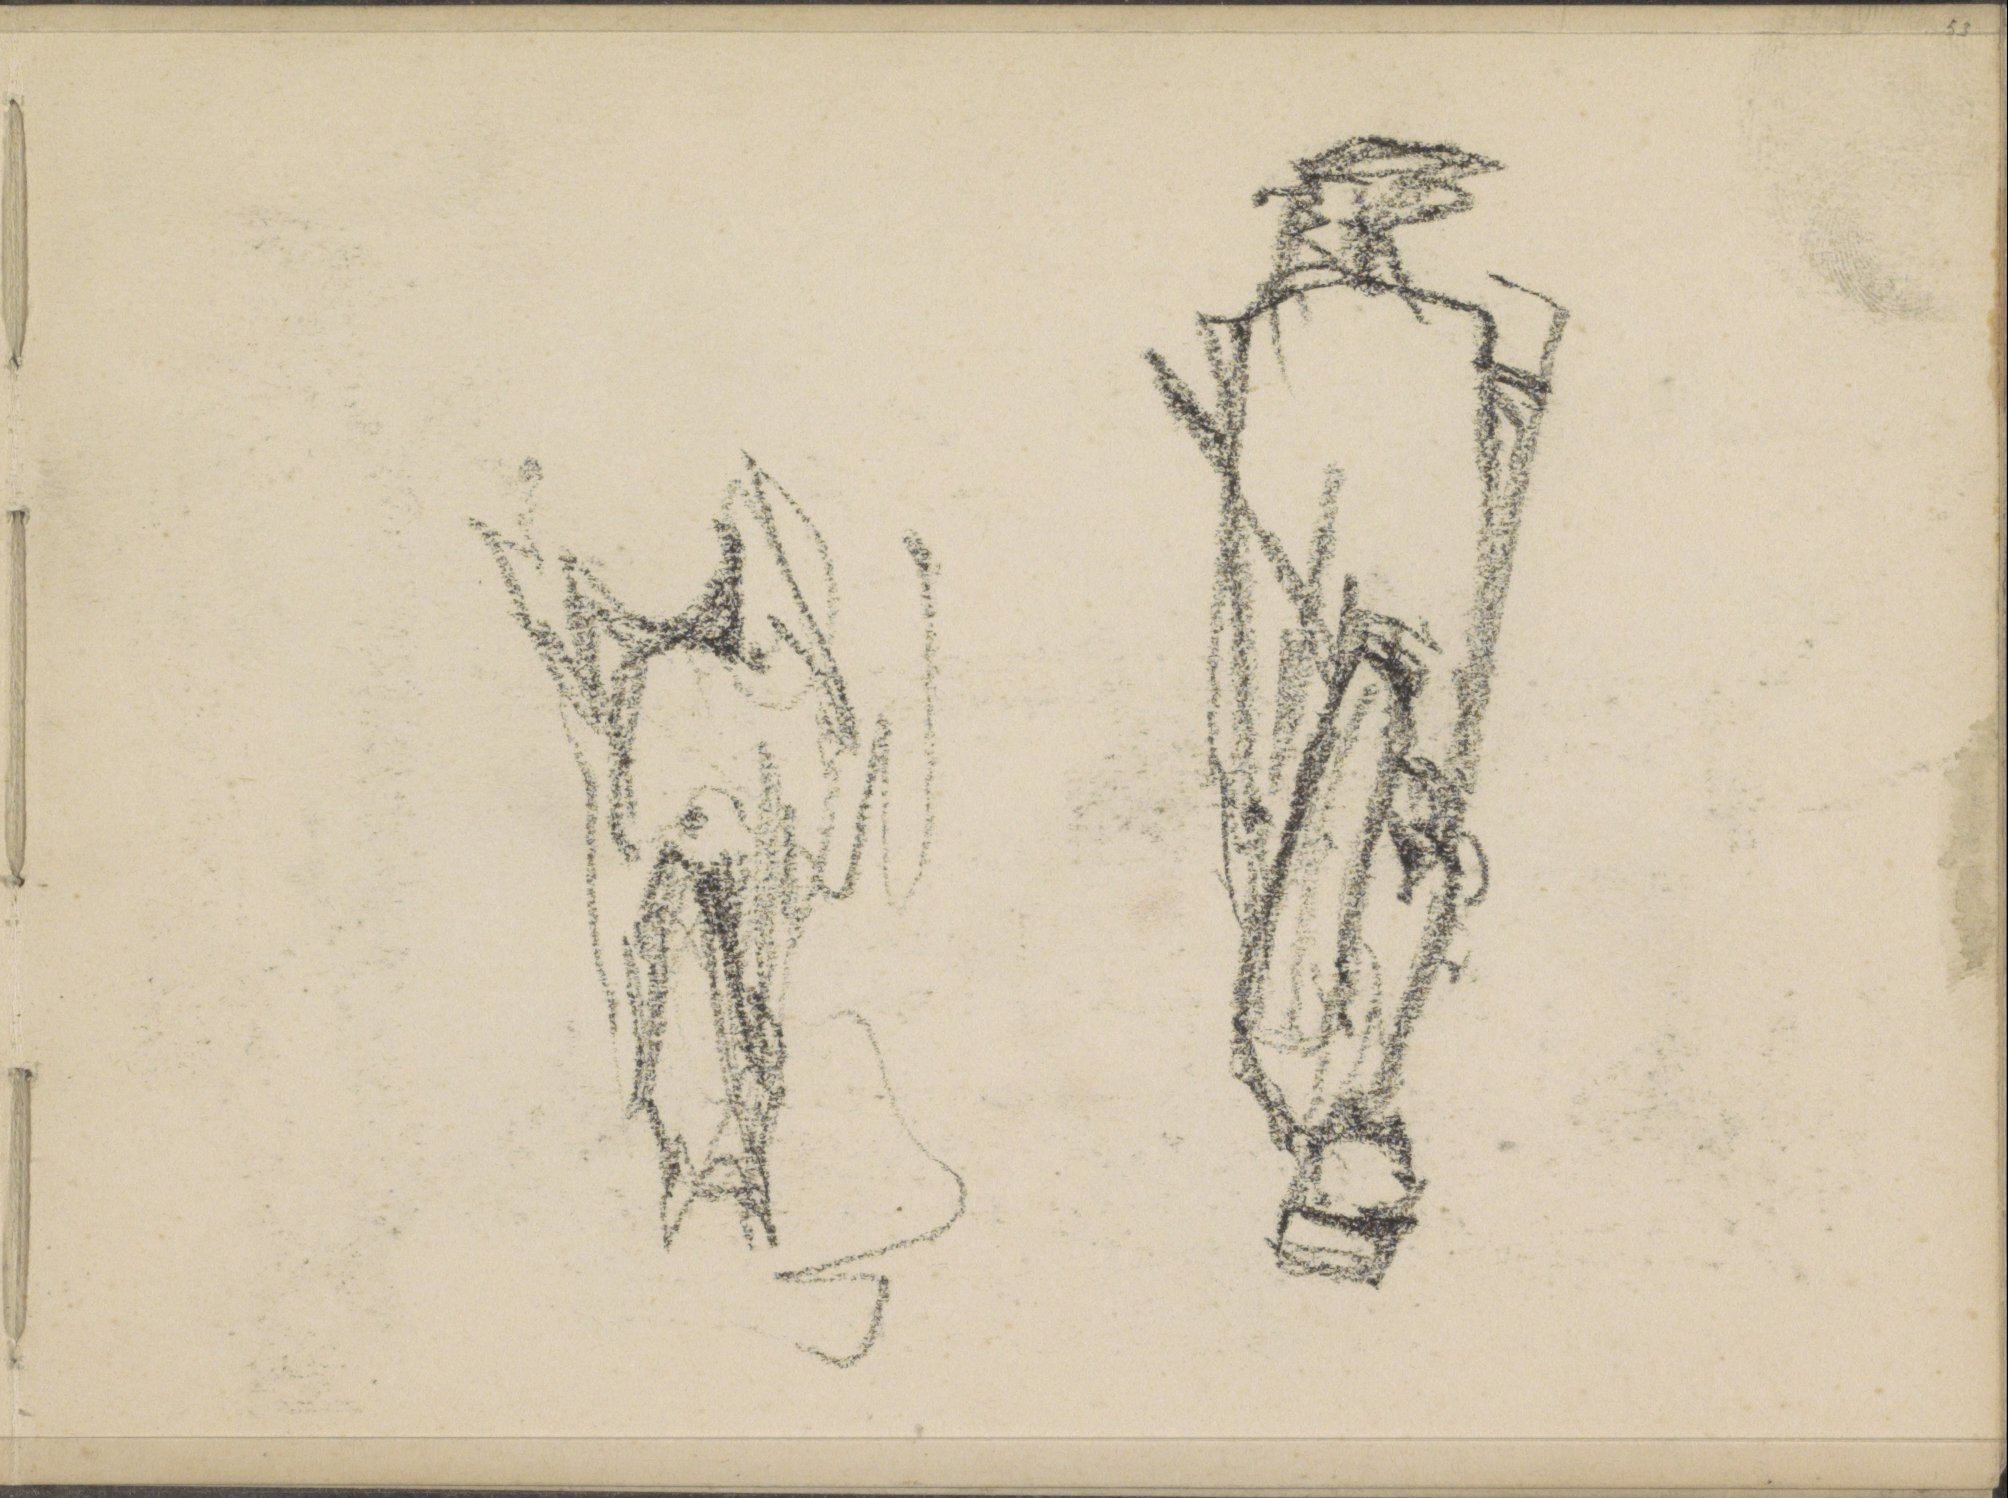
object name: sketchbook leaf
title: Man in een lange jas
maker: marius bauer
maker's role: draughtsman, print maker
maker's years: 1867-1932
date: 1879-1884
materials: chalk, paper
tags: standing figure, coat (+ men's clothes), walking-stick, staff, adult man, head-gear: hat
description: De man draagt een pet en heeft een stok in zijn hand. Pagina 53 uit een schetsboek met 28 bladen.